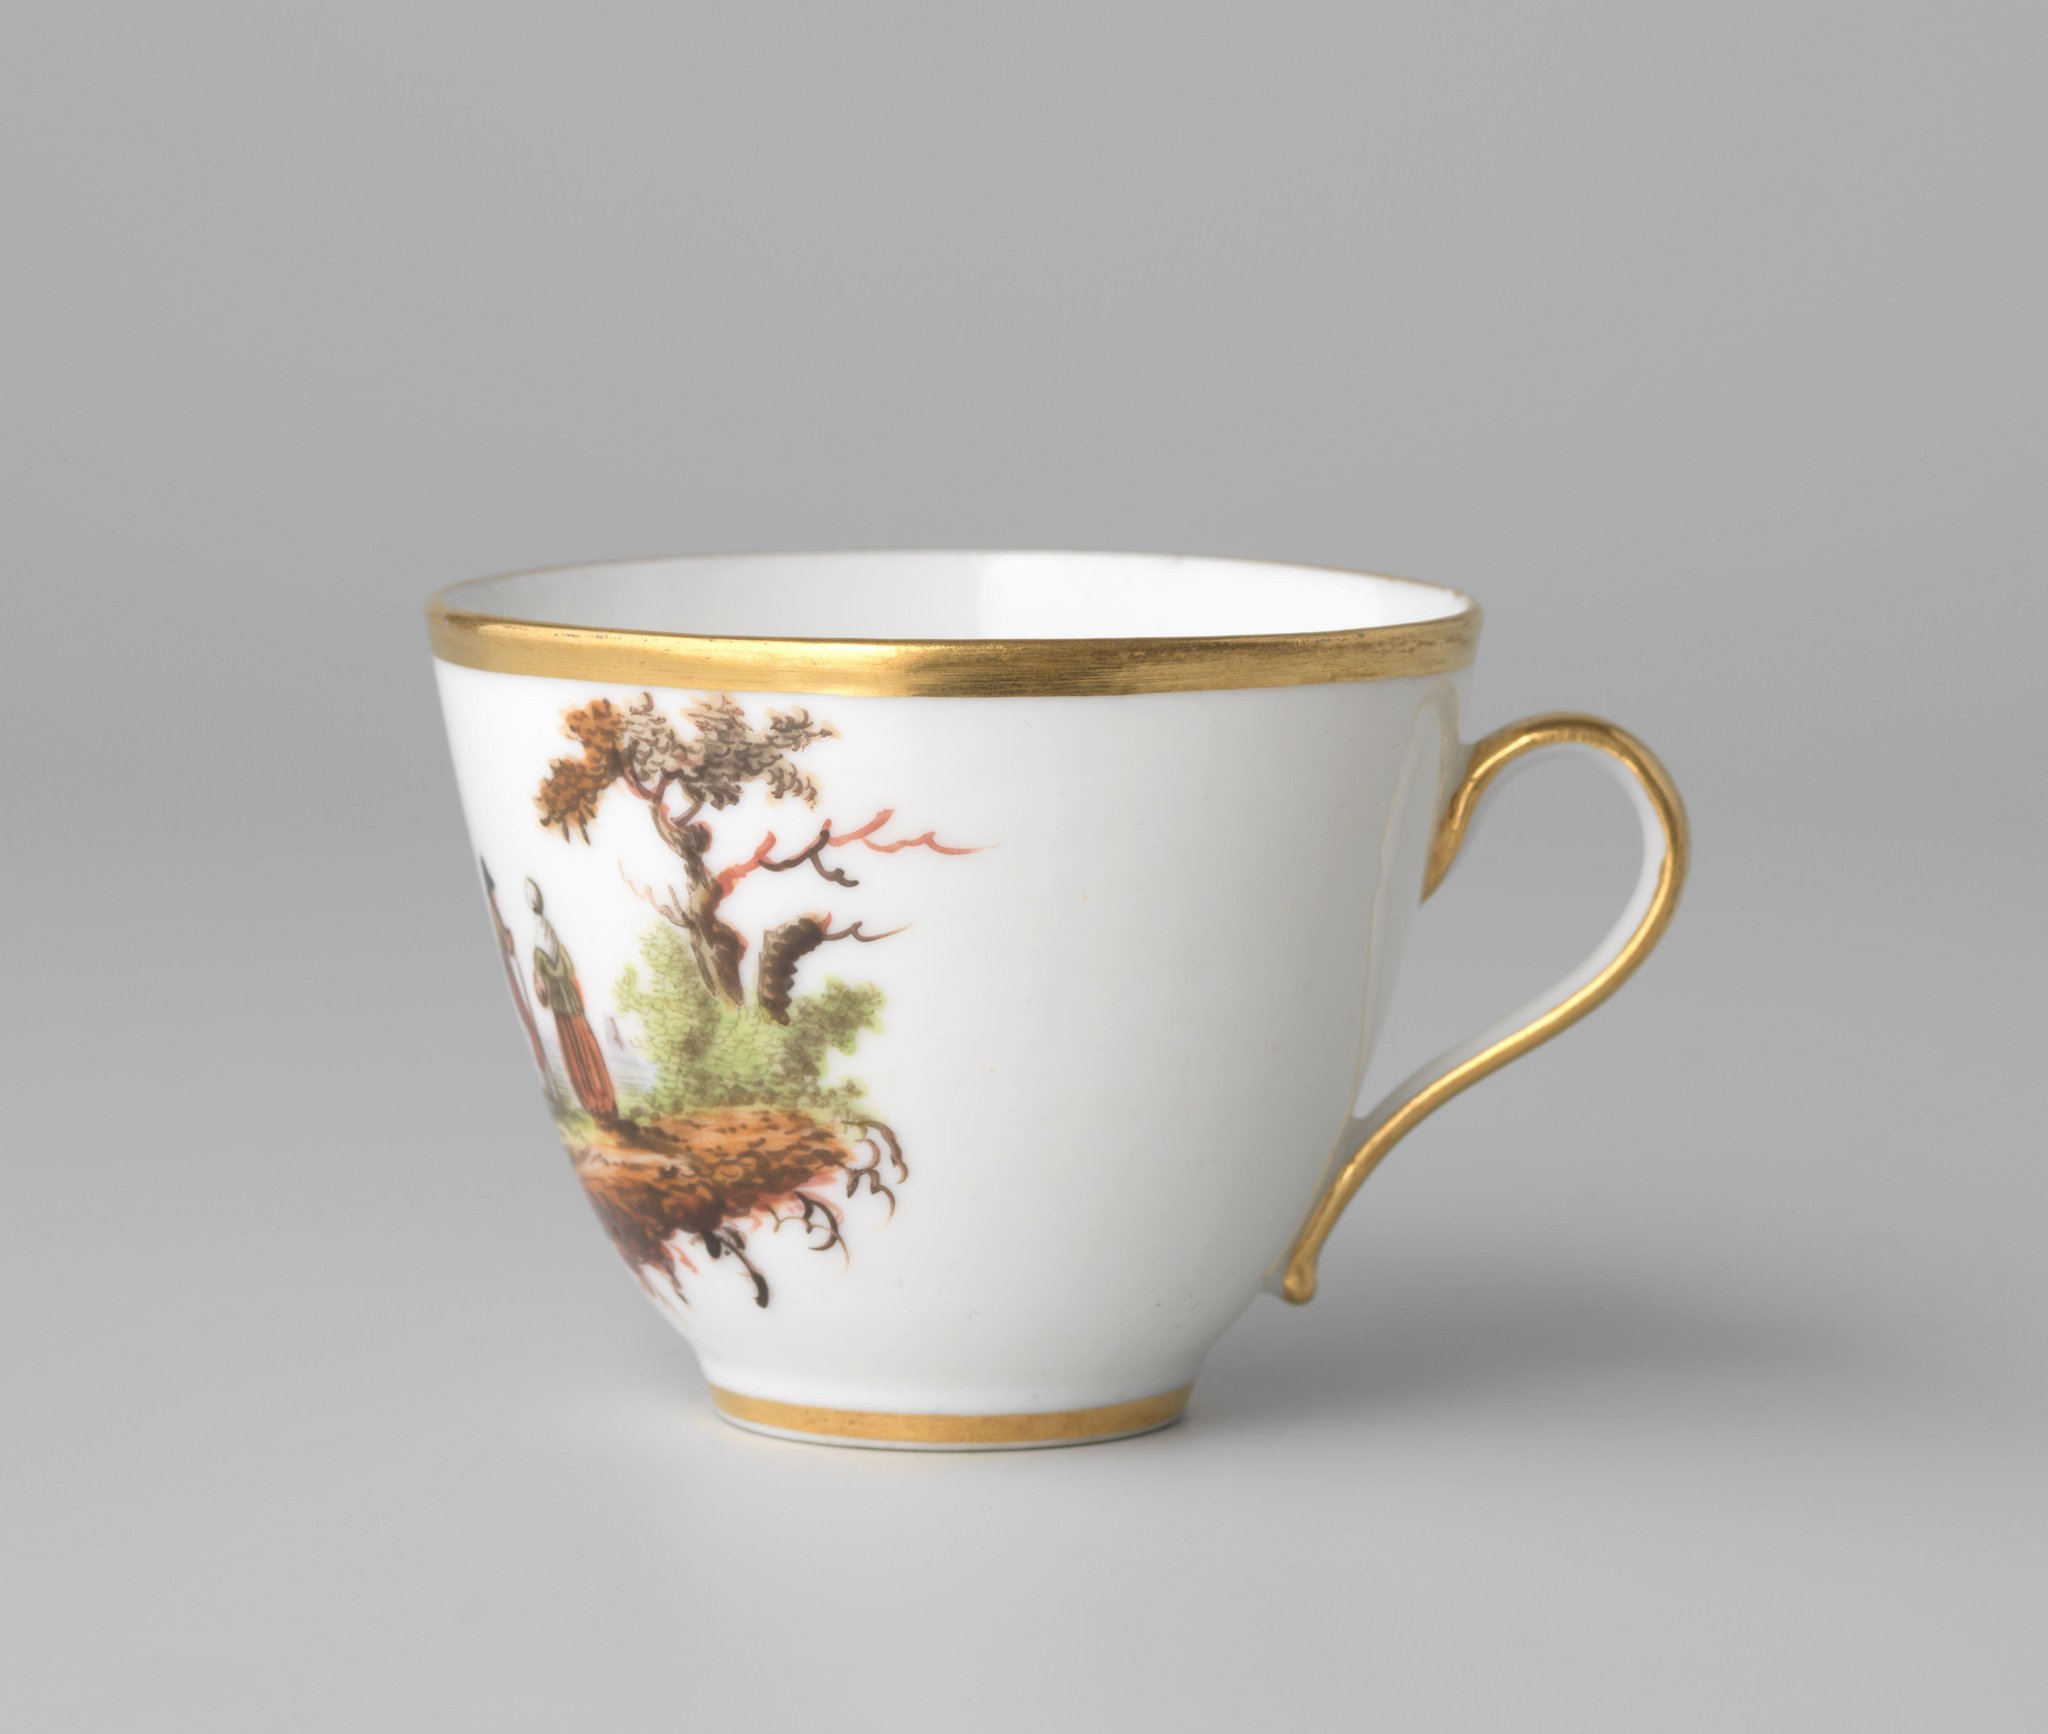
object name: cup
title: Kop met riviergezicht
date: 1809-1814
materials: porcelain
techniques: painted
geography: nieuwer-amstel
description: Kop versierd met een man en vrouw in een veelkleurig rivierlandschap. Langs de randen en oor een gouden rand. Gemerkt: Amstel.